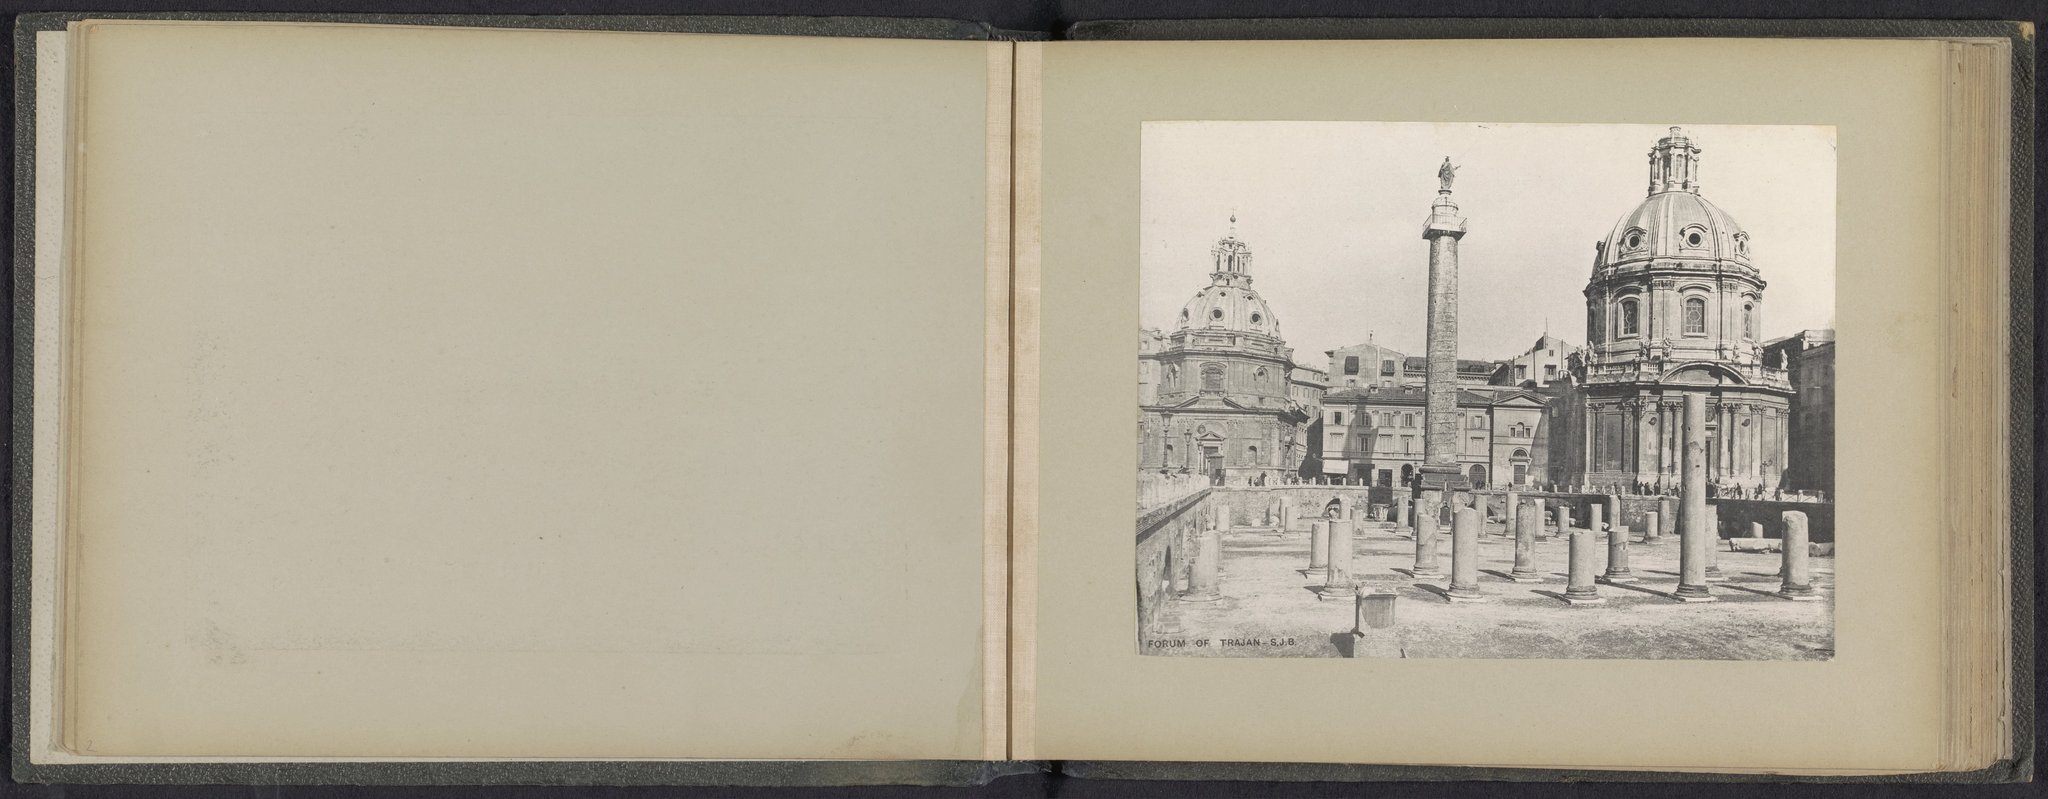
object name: page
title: Forum of Trajan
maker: samuel j. beckett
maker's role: fotograaf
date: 1890-1900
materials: paper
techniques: photograph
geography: forum of trajan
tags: landscape with ruins, façade (of house or building)